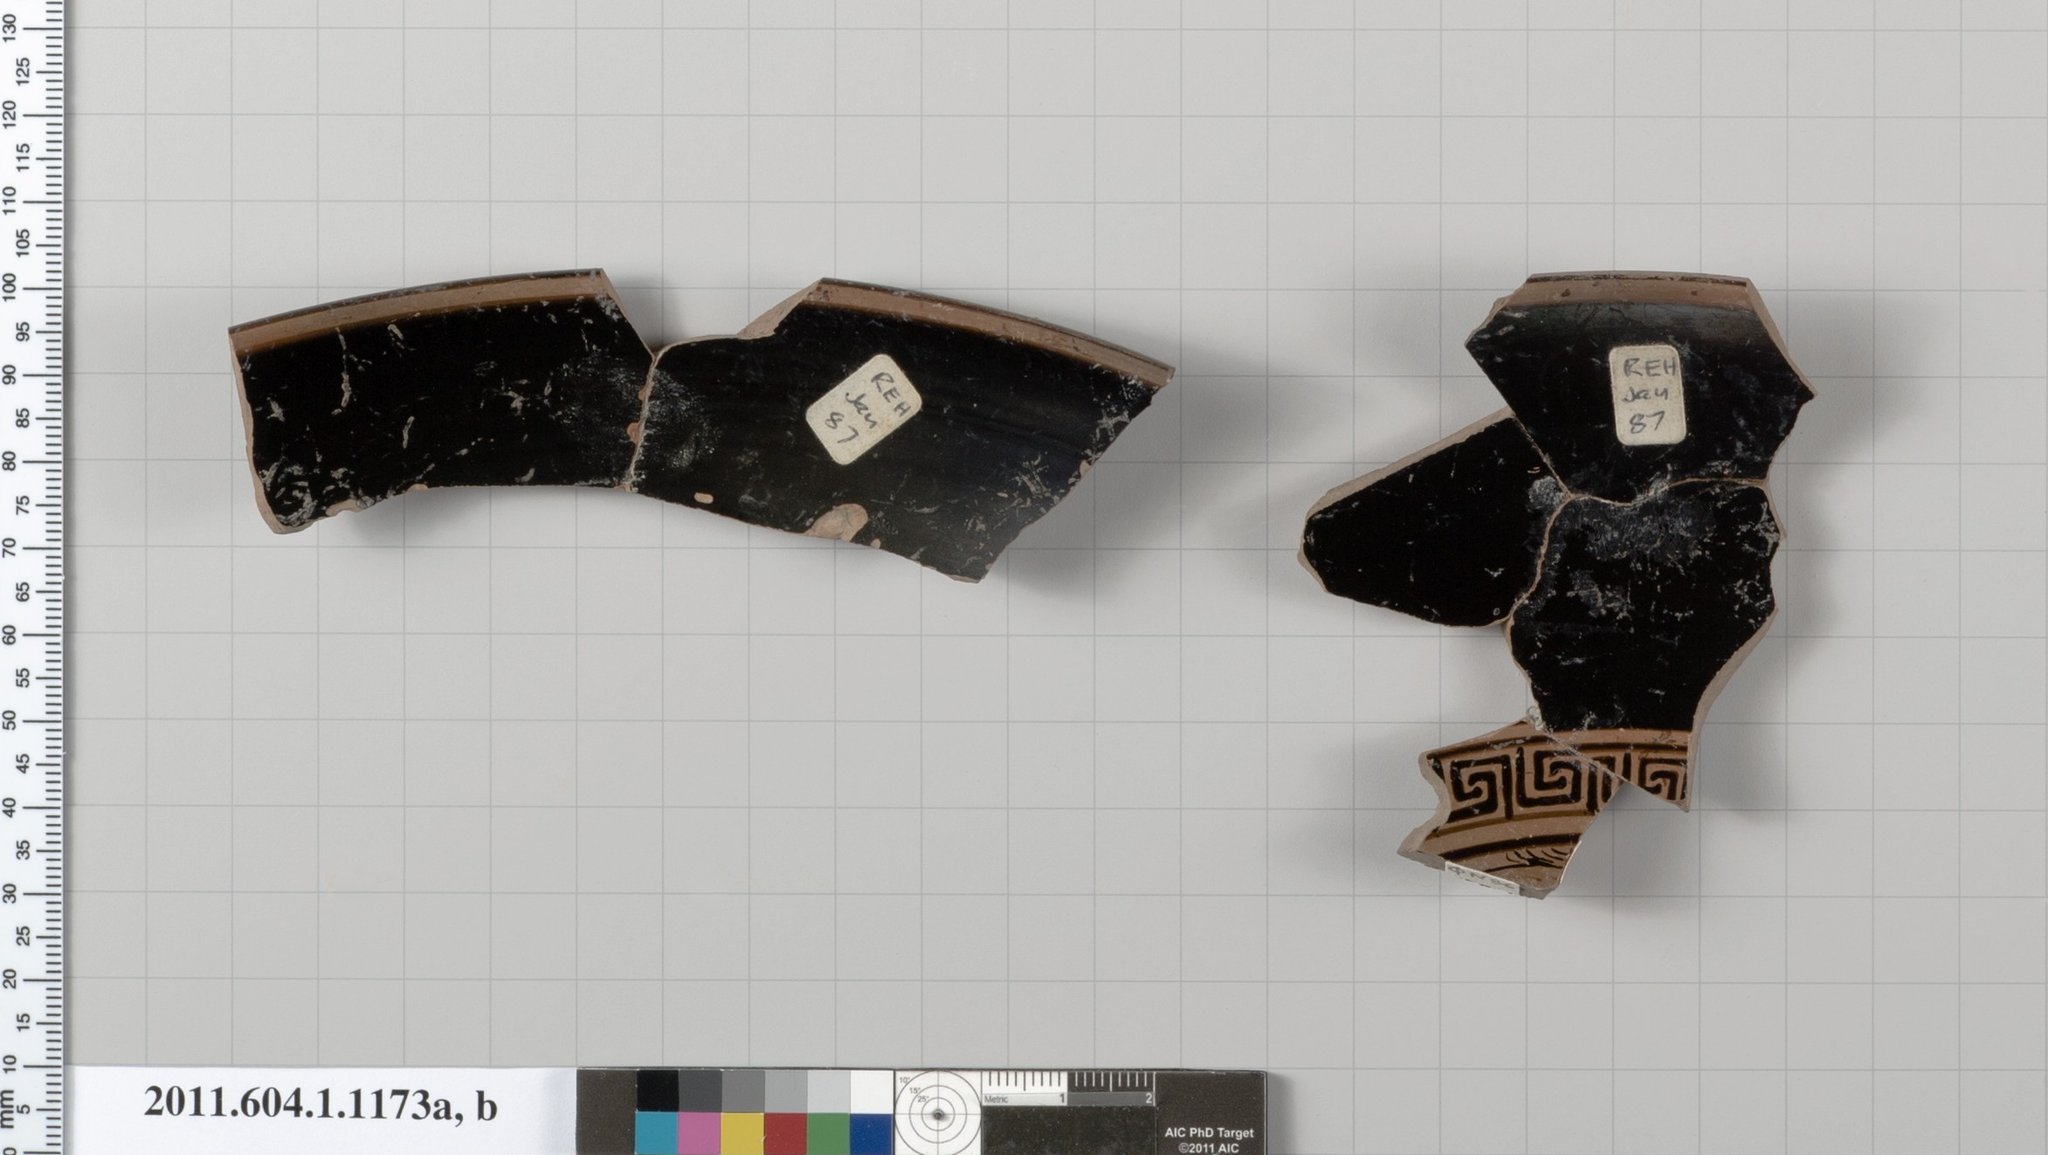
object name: kylix fragment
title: Terracotta rim fragments of a kylix (drinking cup)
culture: greek, attic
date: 490-480 BCE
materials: terracotta